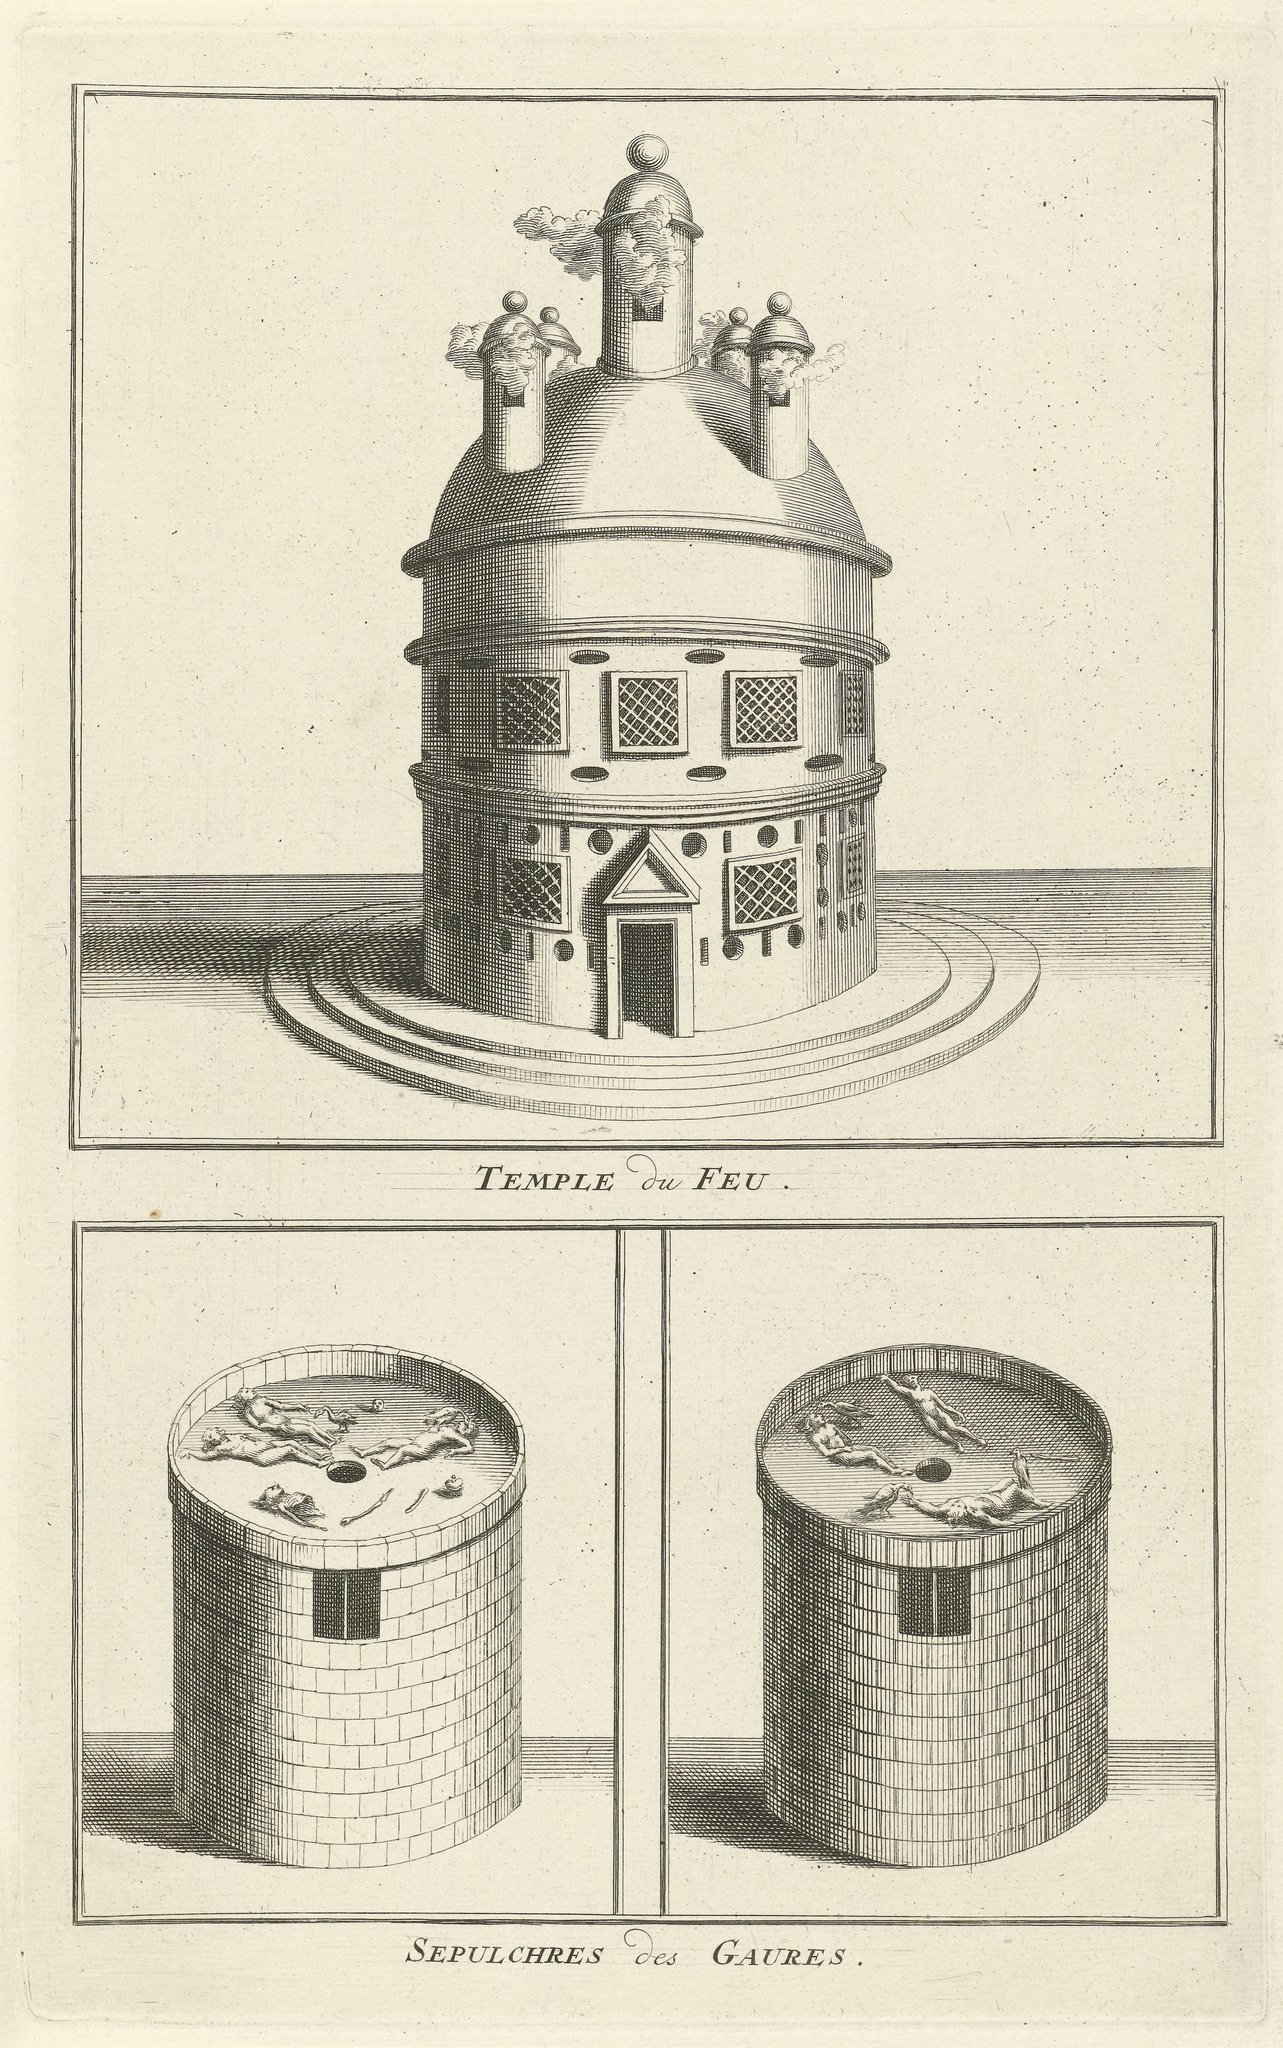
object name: print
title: Perzische tempel en grafmonumenten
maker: bernard picart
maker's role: draughtsman, print maker, publisher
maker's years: 1673-1733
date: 1728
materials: paper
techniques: engraving, etching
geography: amsterdam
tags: grave, tomb, temple, shrine ~ non-christian religions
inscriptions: collector's mark: Lugt 2233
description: Tweede staat van deze prent gebruikt in: Picart, Bernard. Naaukeurige beschryving der uitwendige godtsdienst-plichten, kerk-zeden en gewoontens van alle volkeren der waereldt, deel IV. [Vertaald in het Nederlands door] Moubach, Abraham. Den Haag, Amsterdam, Rotterdam: Rutgert Alberts, Hermannus Uytwerf, Jan Daniel Beman, Isaac van der Kloot, 1727-1738.